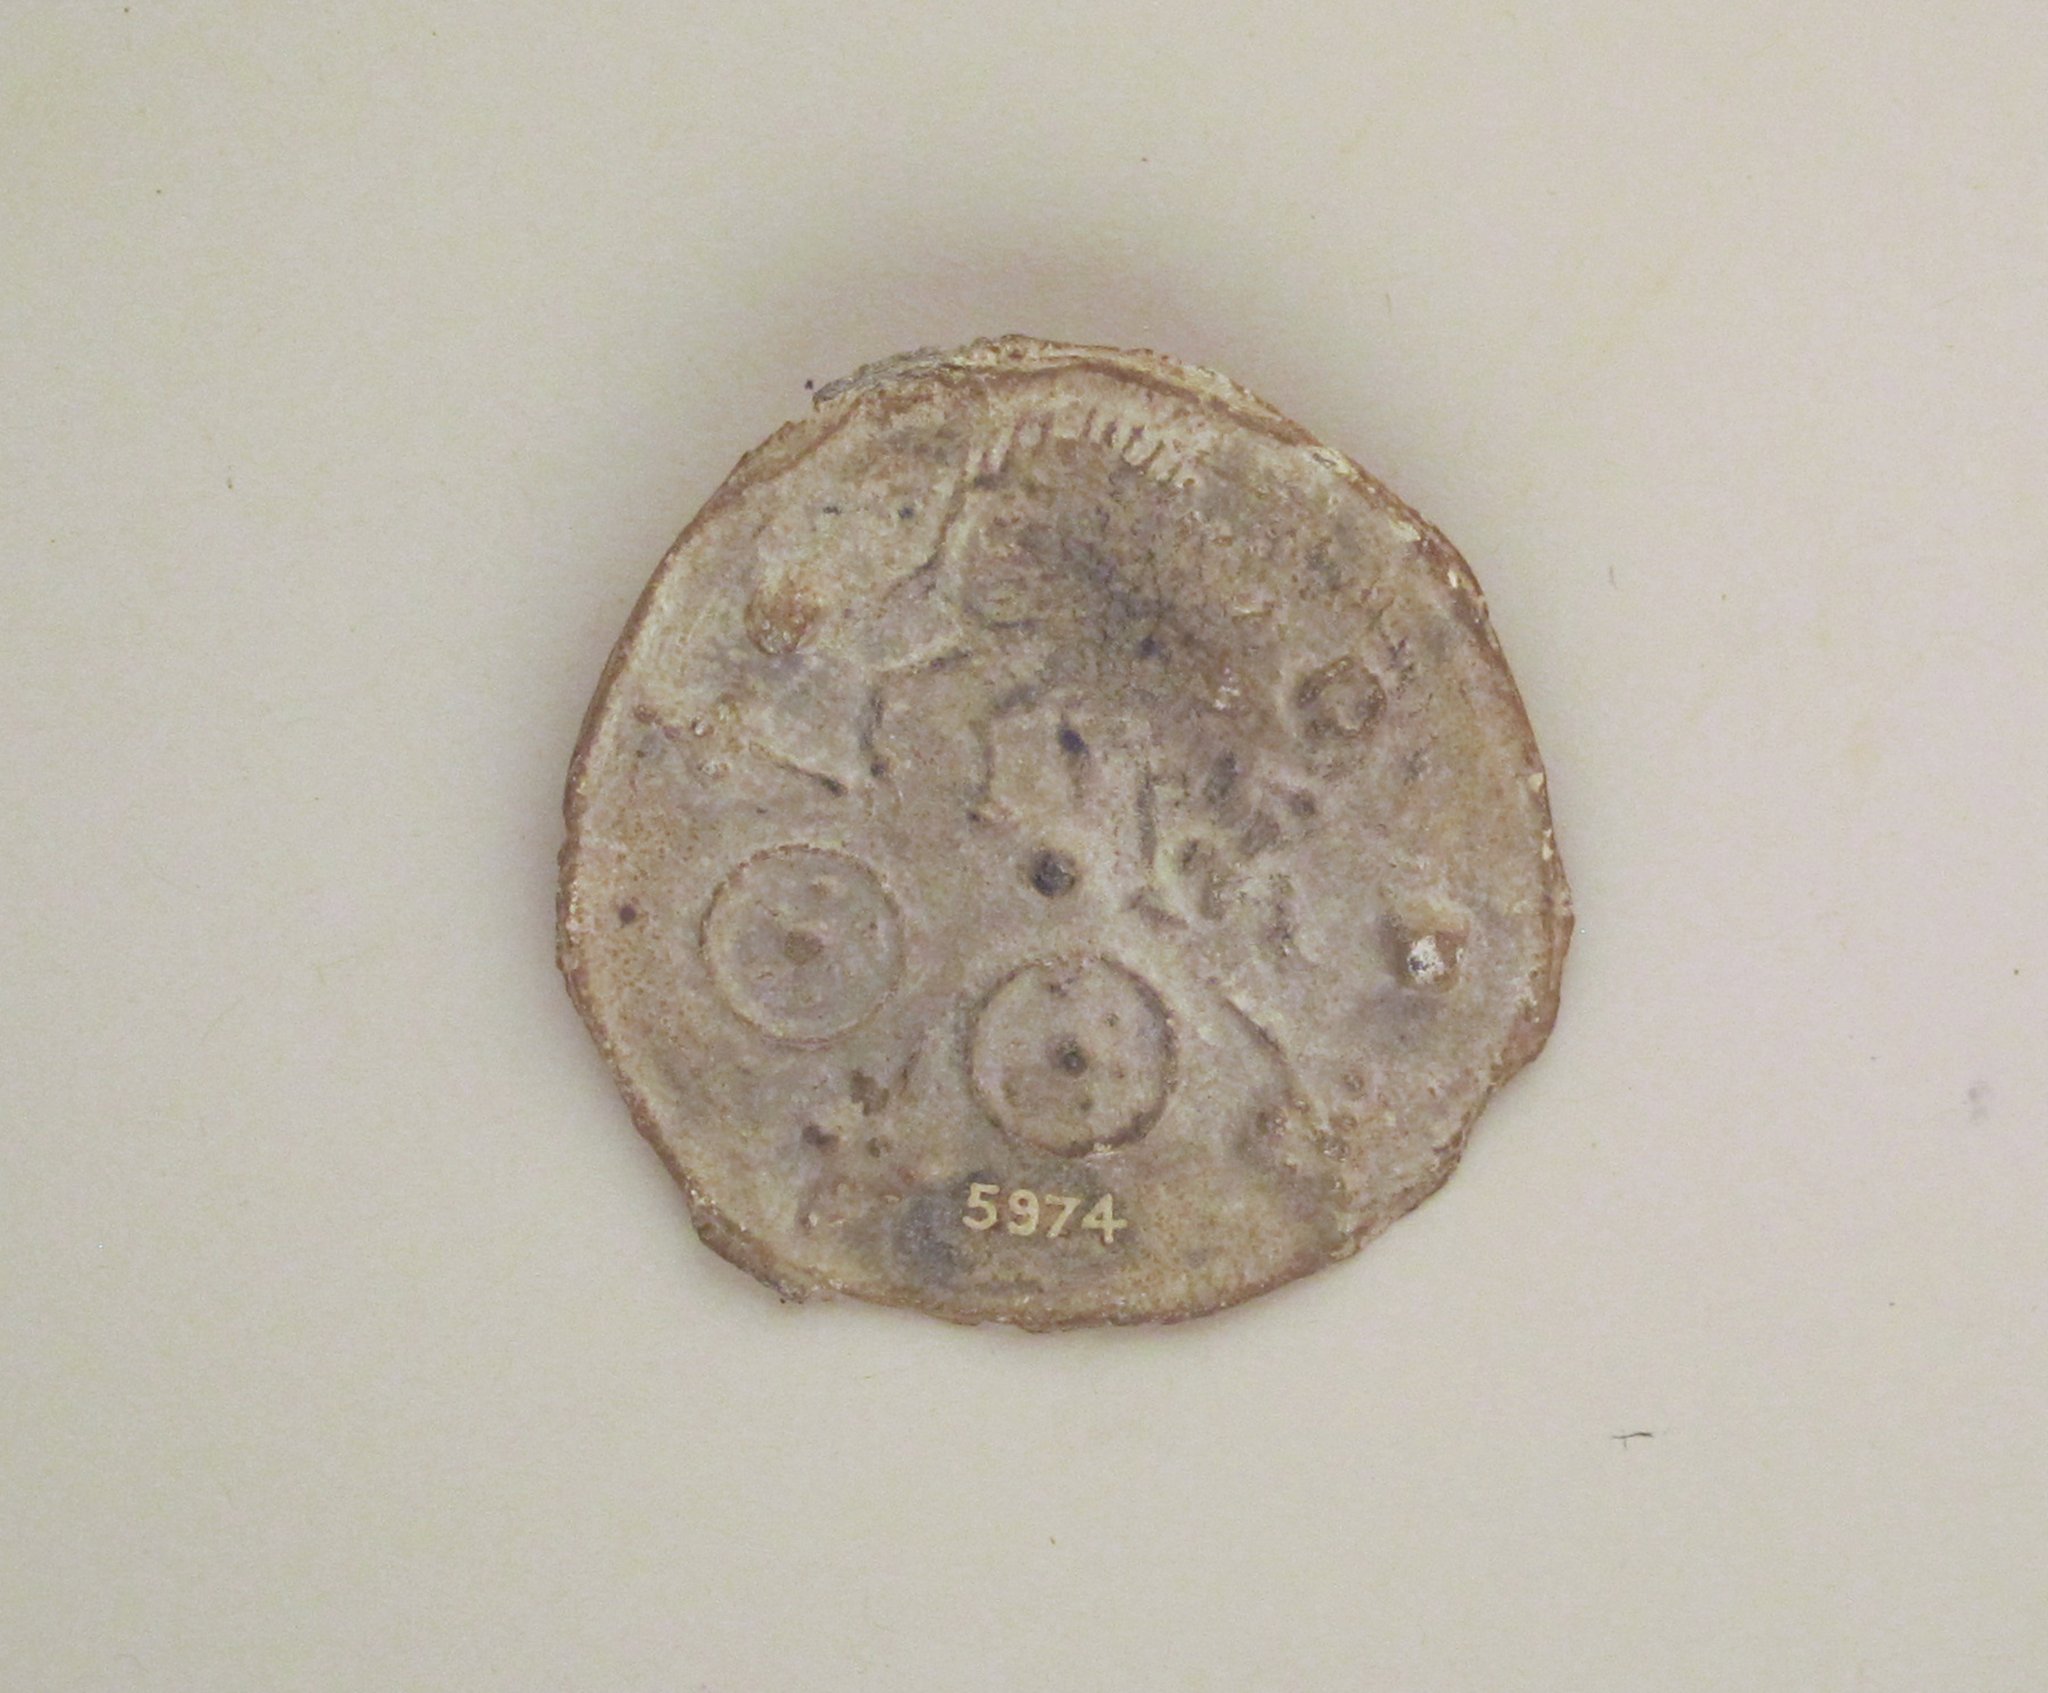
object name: offering table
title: Lead votive roundel with table offerings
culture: roman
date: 670 BCE-330 CE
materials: lead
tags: boars